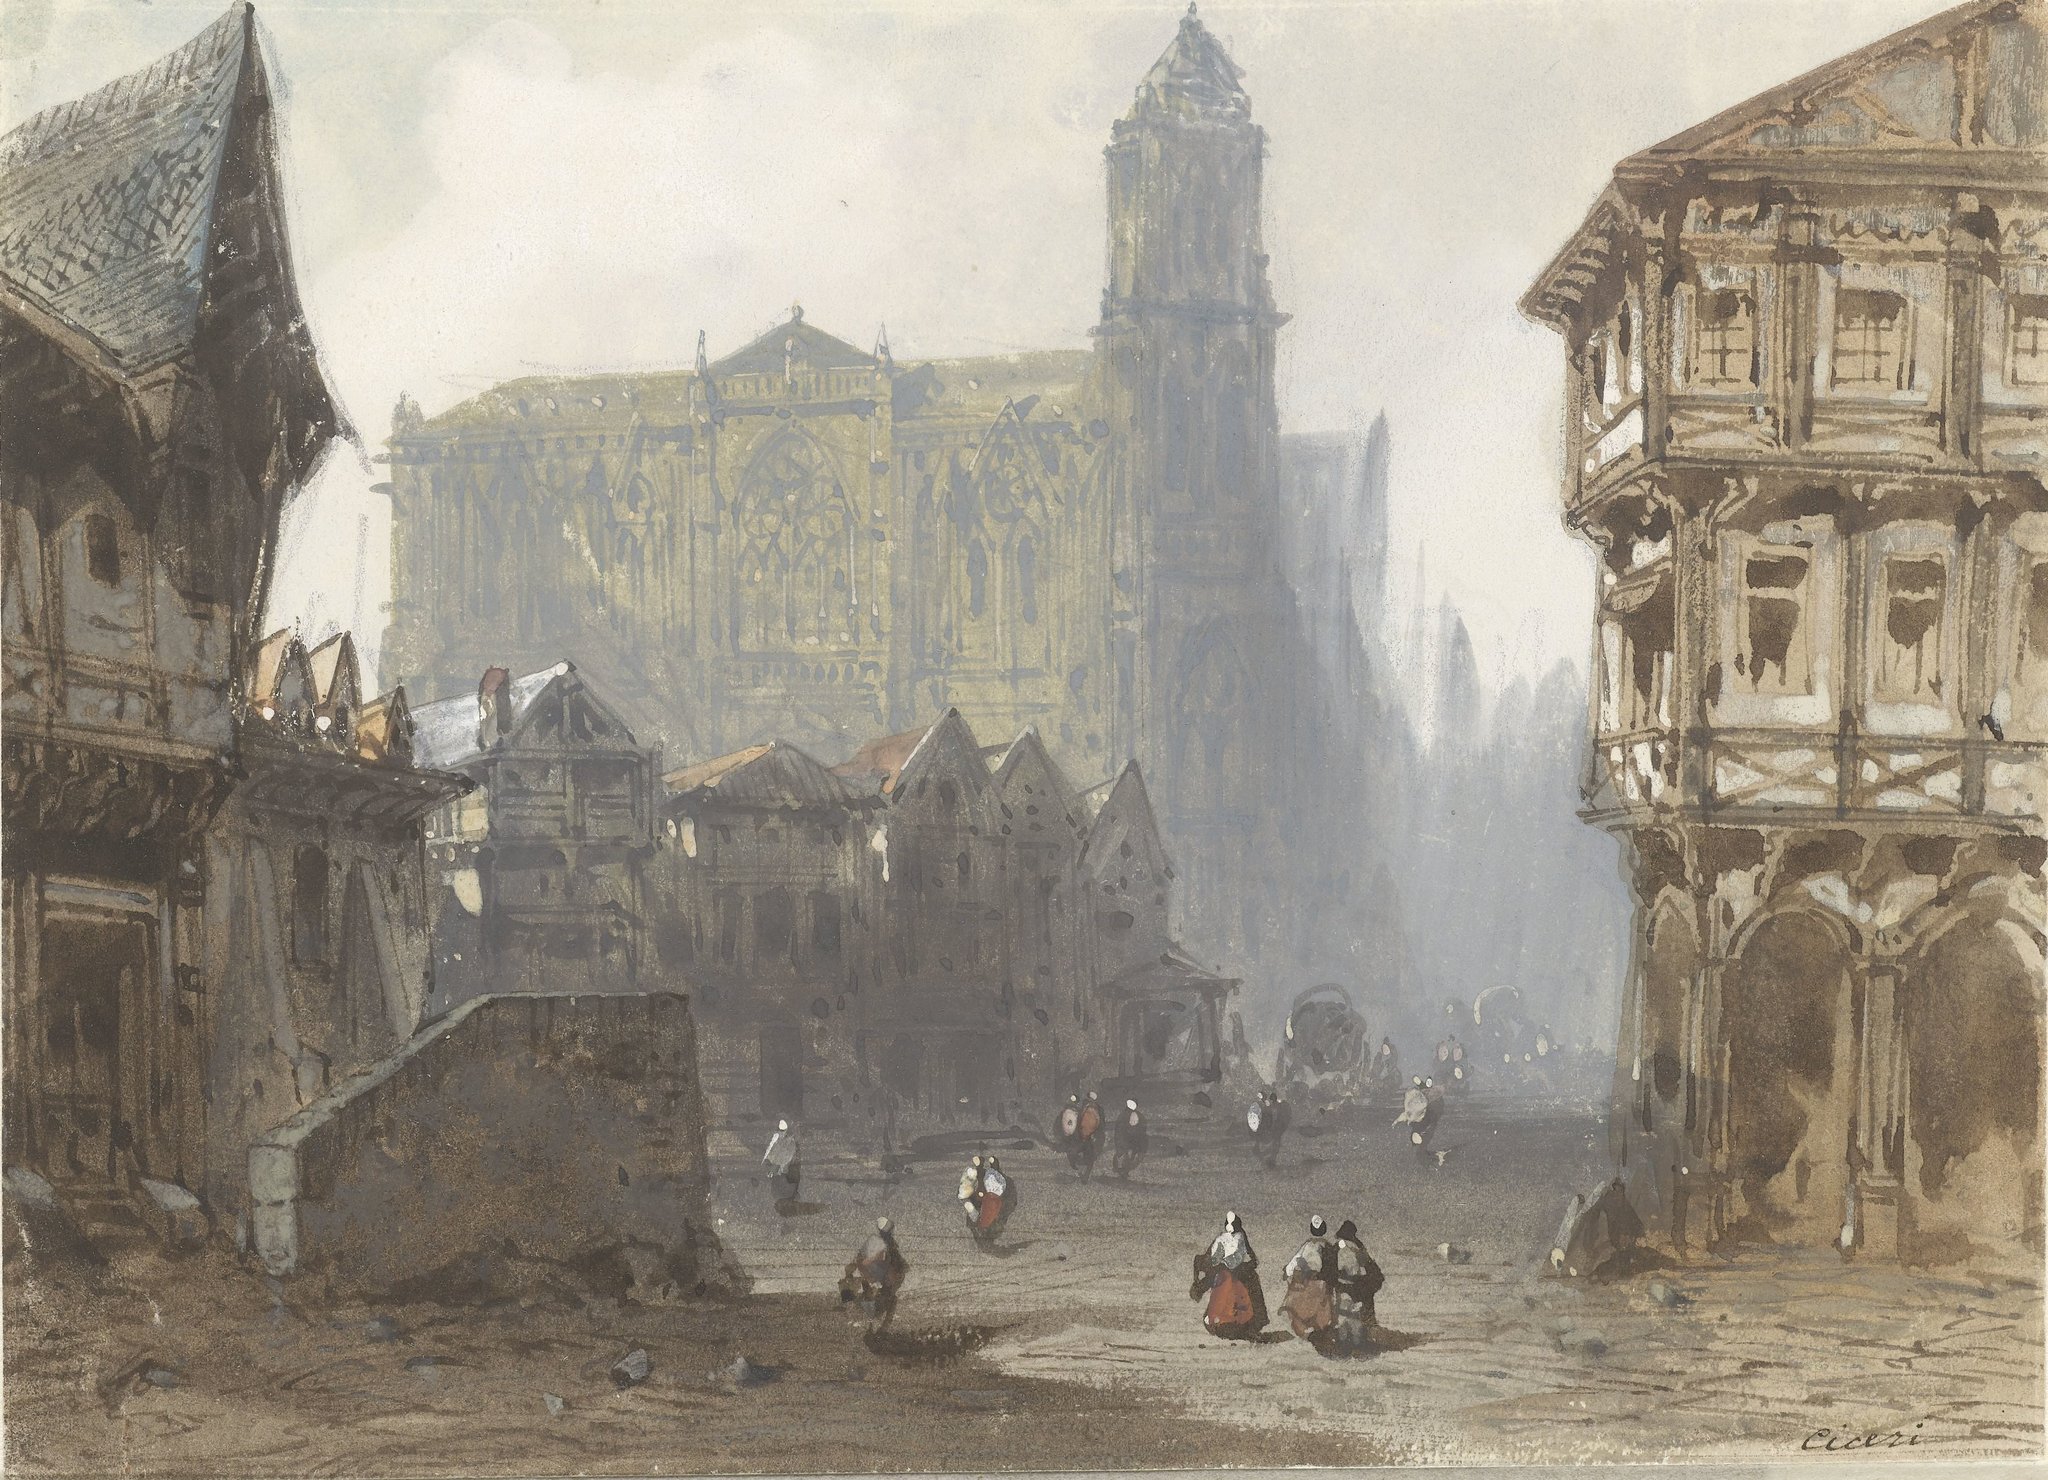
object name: drawing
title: Het Oude Marktplein te Rouen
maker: pierre luc charles cicéri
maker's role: draughtsman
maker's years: 1782-1868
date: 1792-1868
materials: gouache, paint, paper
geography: rouen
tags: square, place, circus, etc. (+ city(-scape) with figures, staffage)